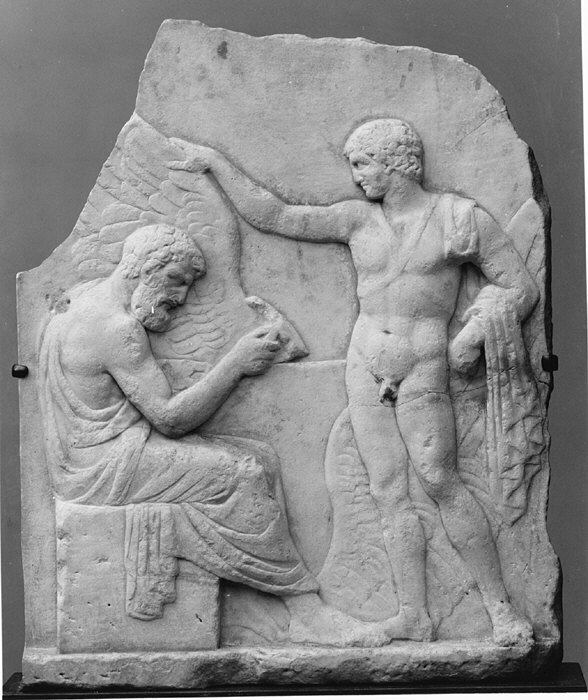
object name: relief of daedalus and icarus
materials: marble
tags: men,male nudes